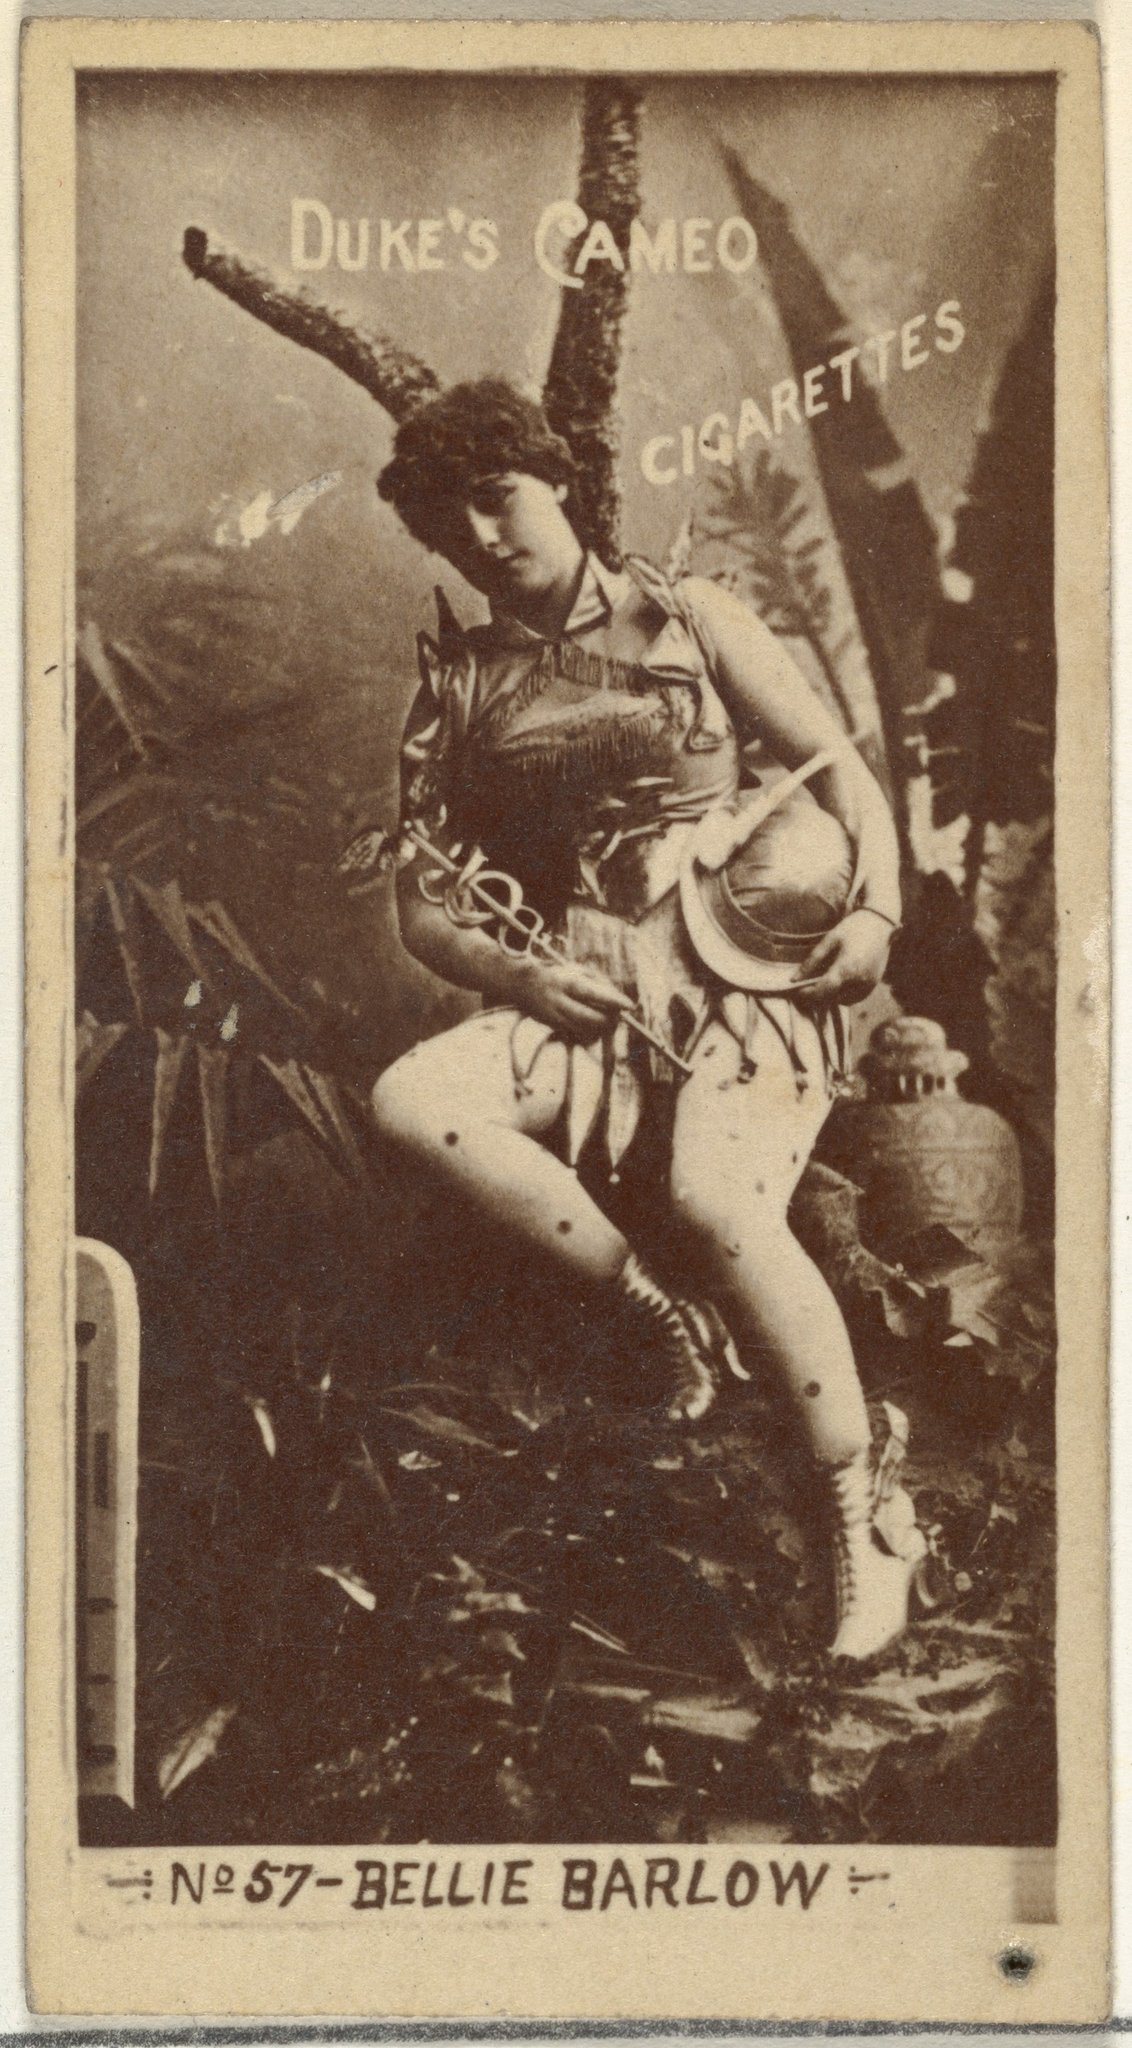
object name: photograph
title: Card Number 57, Billie Barlow, from the Actors and Actresses series (N145-4) issued by Duke Sons & Co. to promote Cameo Cigarettes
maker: w. duke, sons & co.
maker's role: publisher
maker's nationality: american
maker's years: 1870-1920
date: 1880-1889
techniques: albumen silver print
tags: women,actresses